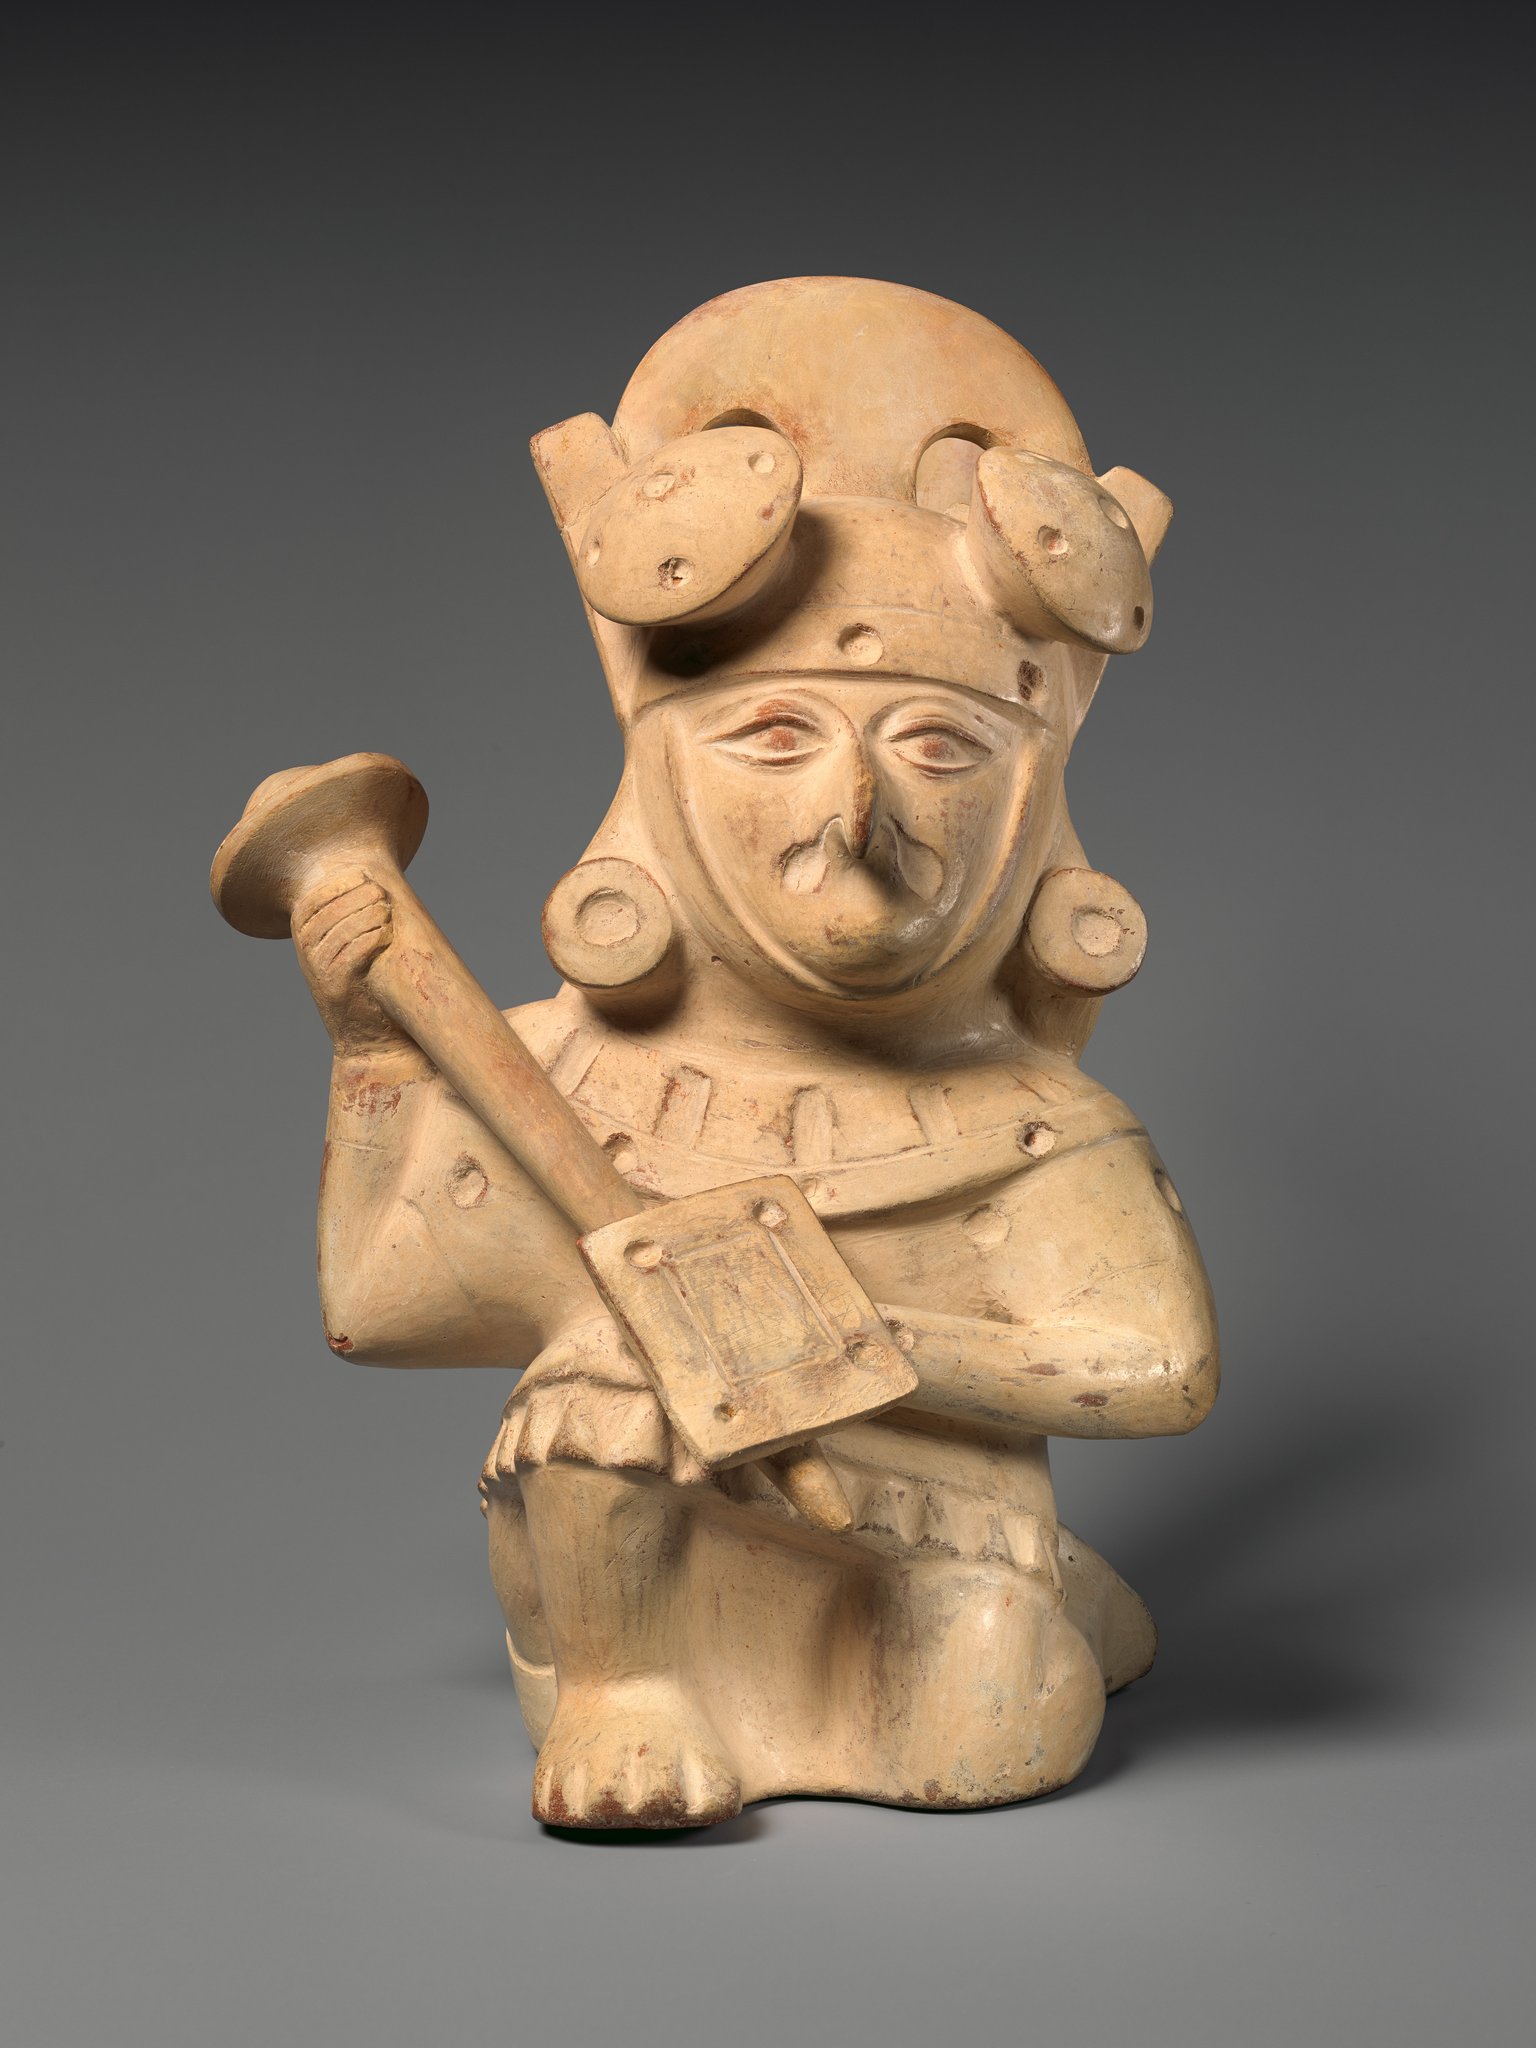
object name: bottle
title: Stirrup spout bottle with bird warrior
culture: moche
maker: moche artist(s)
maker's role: artist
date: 500-800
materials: ceramic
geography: peru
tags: warriors